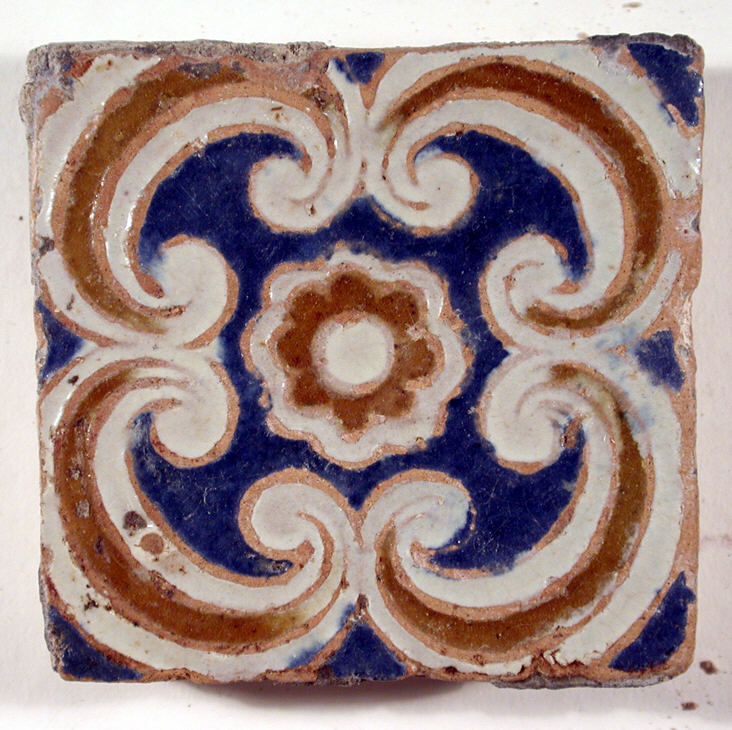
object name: pavement tile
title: Pavement tiles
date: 1501-1700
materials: earthenware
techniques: glazing